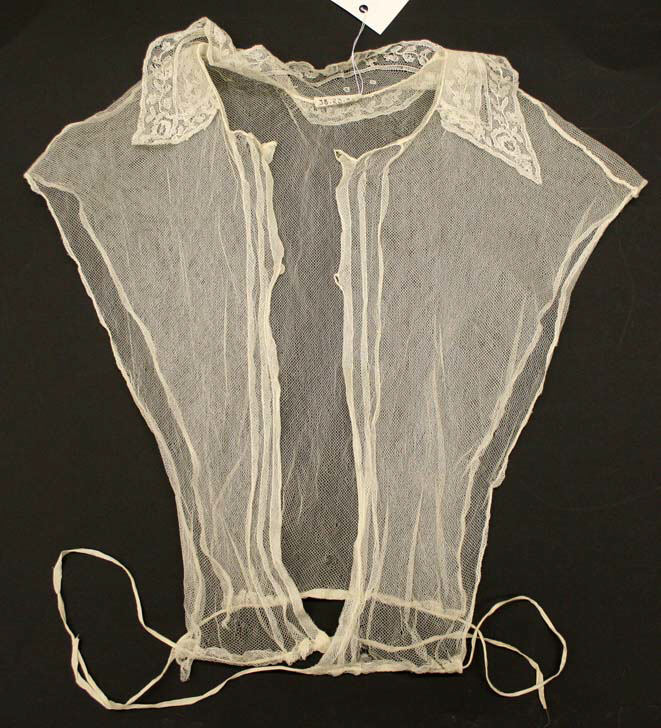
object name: vestee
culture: european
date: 1850-1859